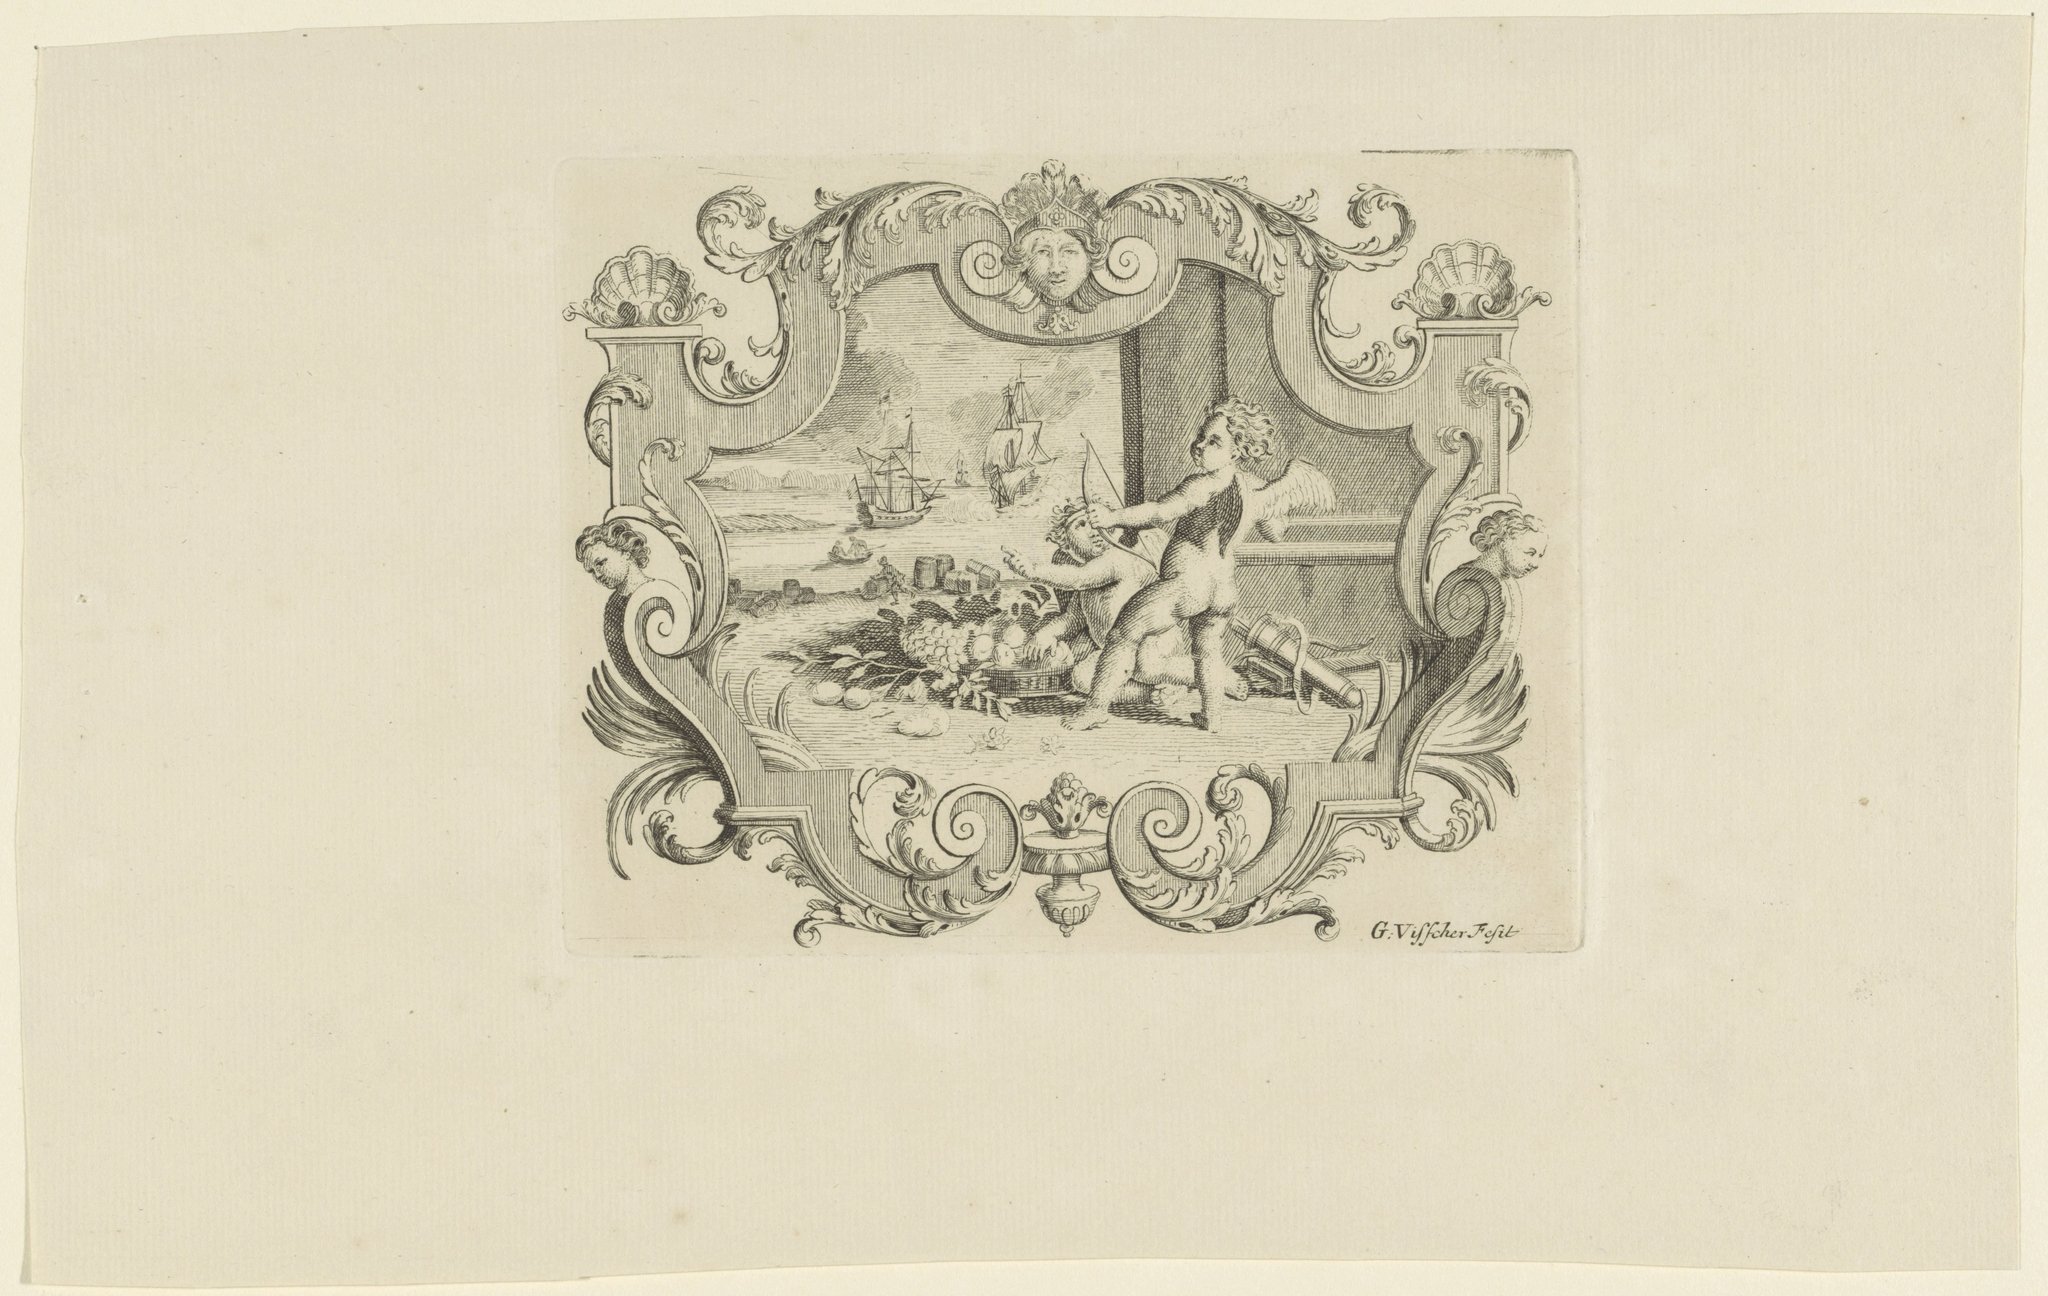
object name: print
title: Amor en putto op een strand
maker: gerrit visscher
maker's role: print maker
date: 1690-1710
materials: paper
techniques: engraving, etching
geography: amsterdam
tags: ornaments ~ art, sailing-ship, sailing-boat, (story of) cupid, amor (eros), cupids: 'amores', 'amoretti', 'putti'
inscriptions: collector's mark: Lugt 2233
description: Amor met boog en putto bij fruitmand op een strand. In het verschiet zeilschepen op zee. De voorstelling is gevat in een ornamenteel kader.